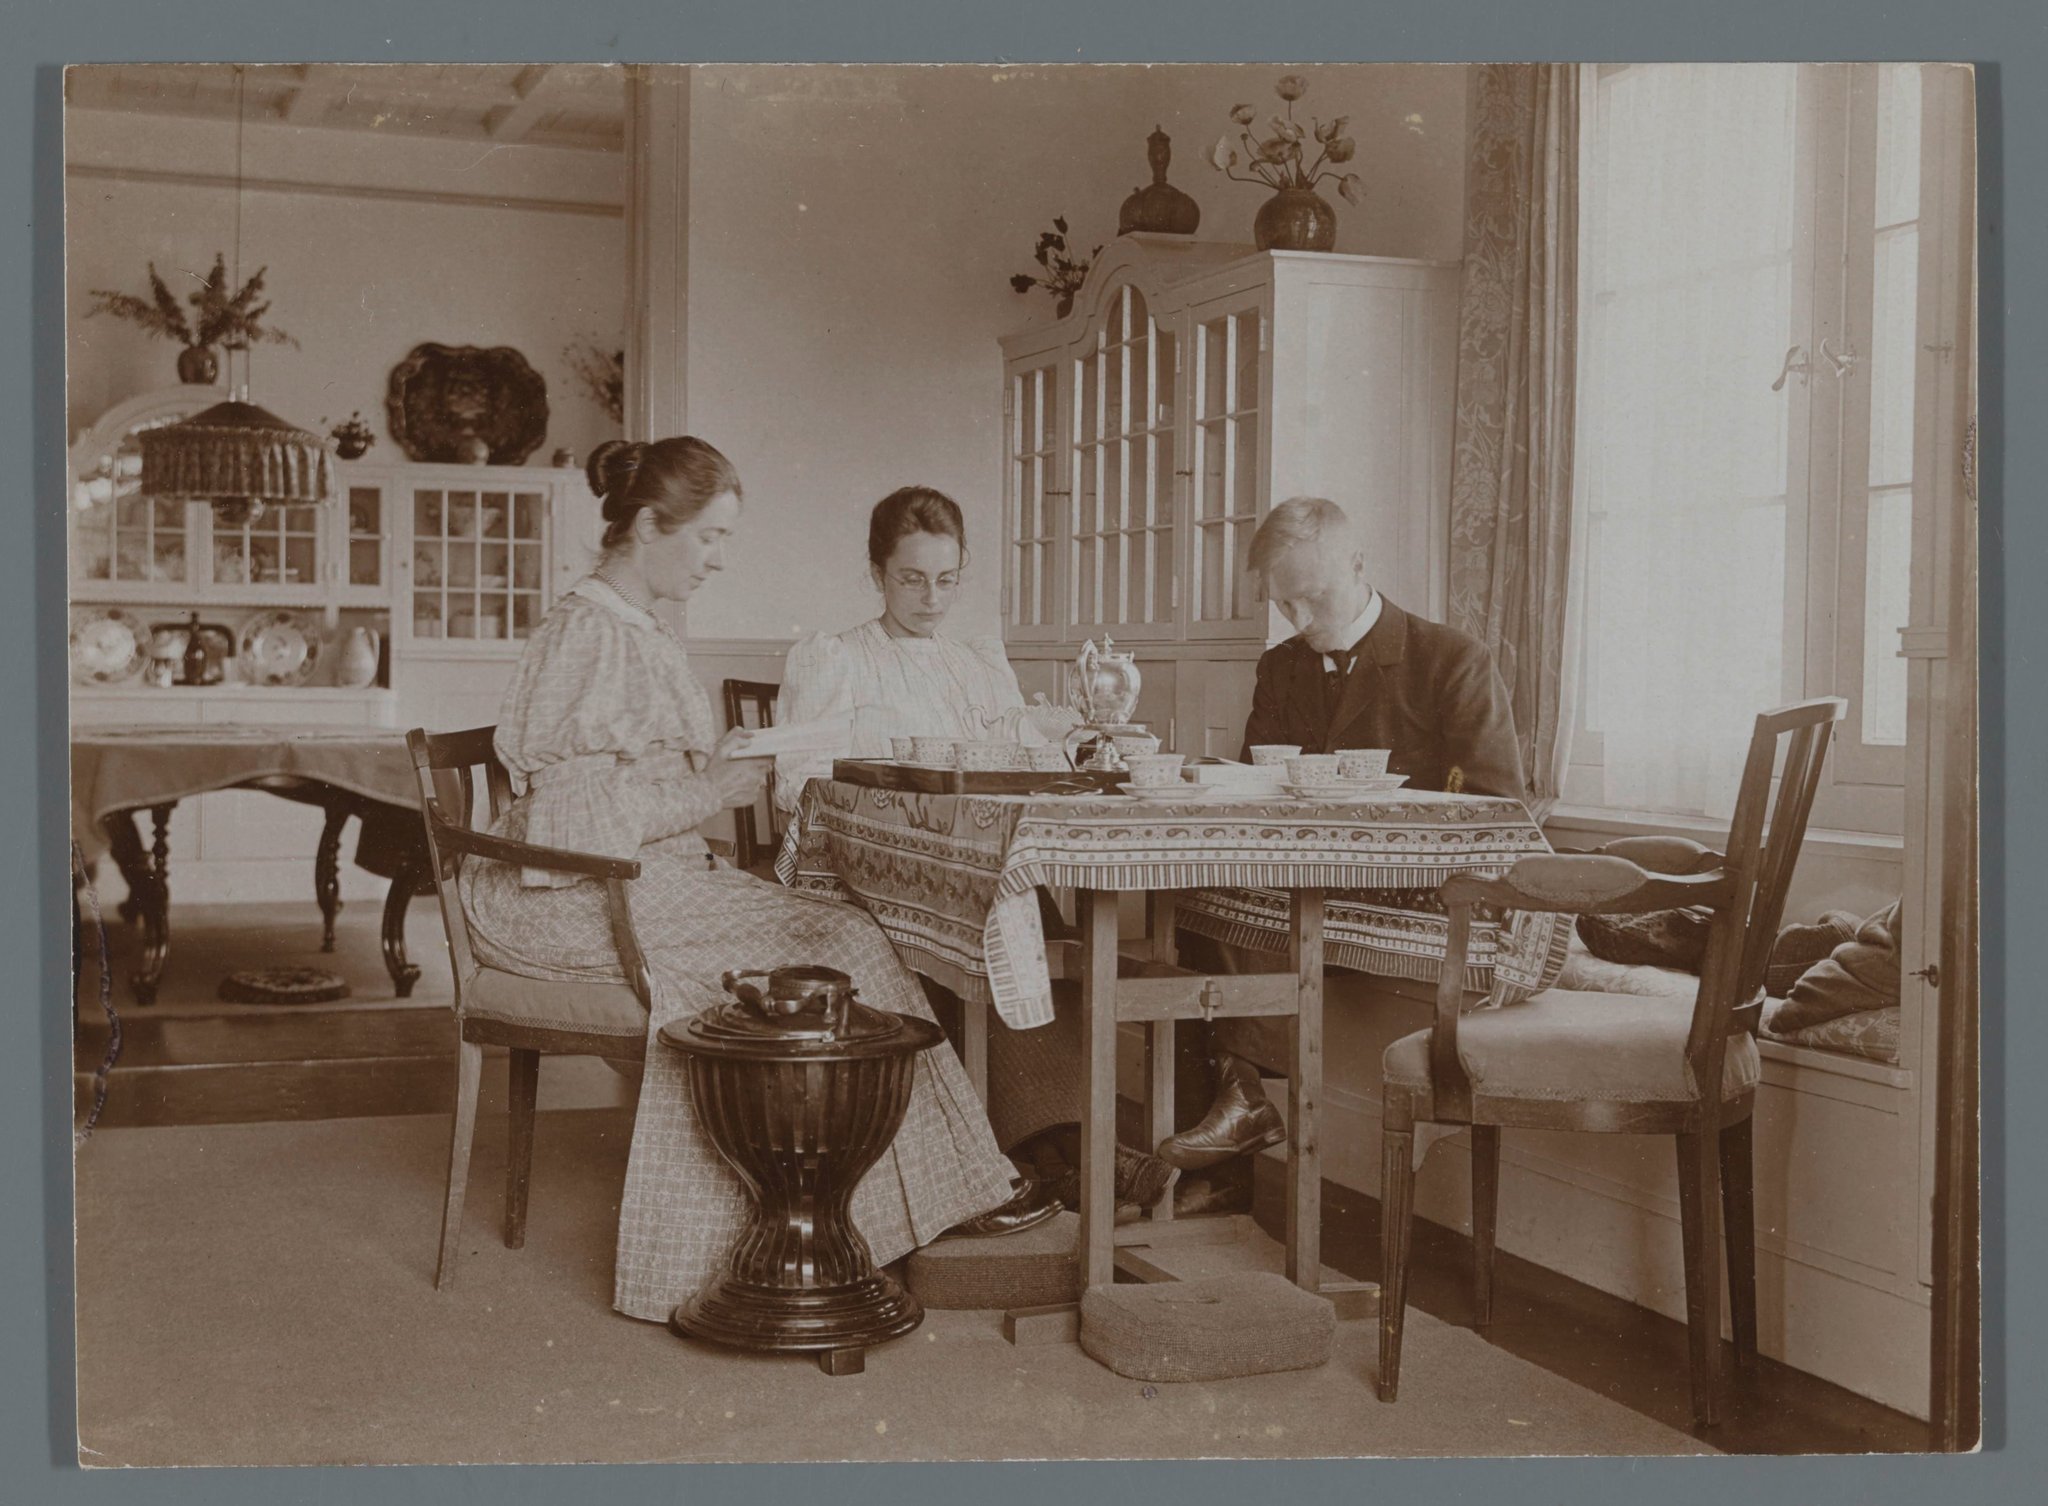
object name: photograph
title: Gezelschap drinkt thee aan tafel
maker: cornelia hendrika jonker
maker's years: 1874-1924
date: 1880-1940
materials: photographic support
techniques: collodion silver print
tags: afternoon tea, anonymous historical persons portrayed in a group, in a group-portrait